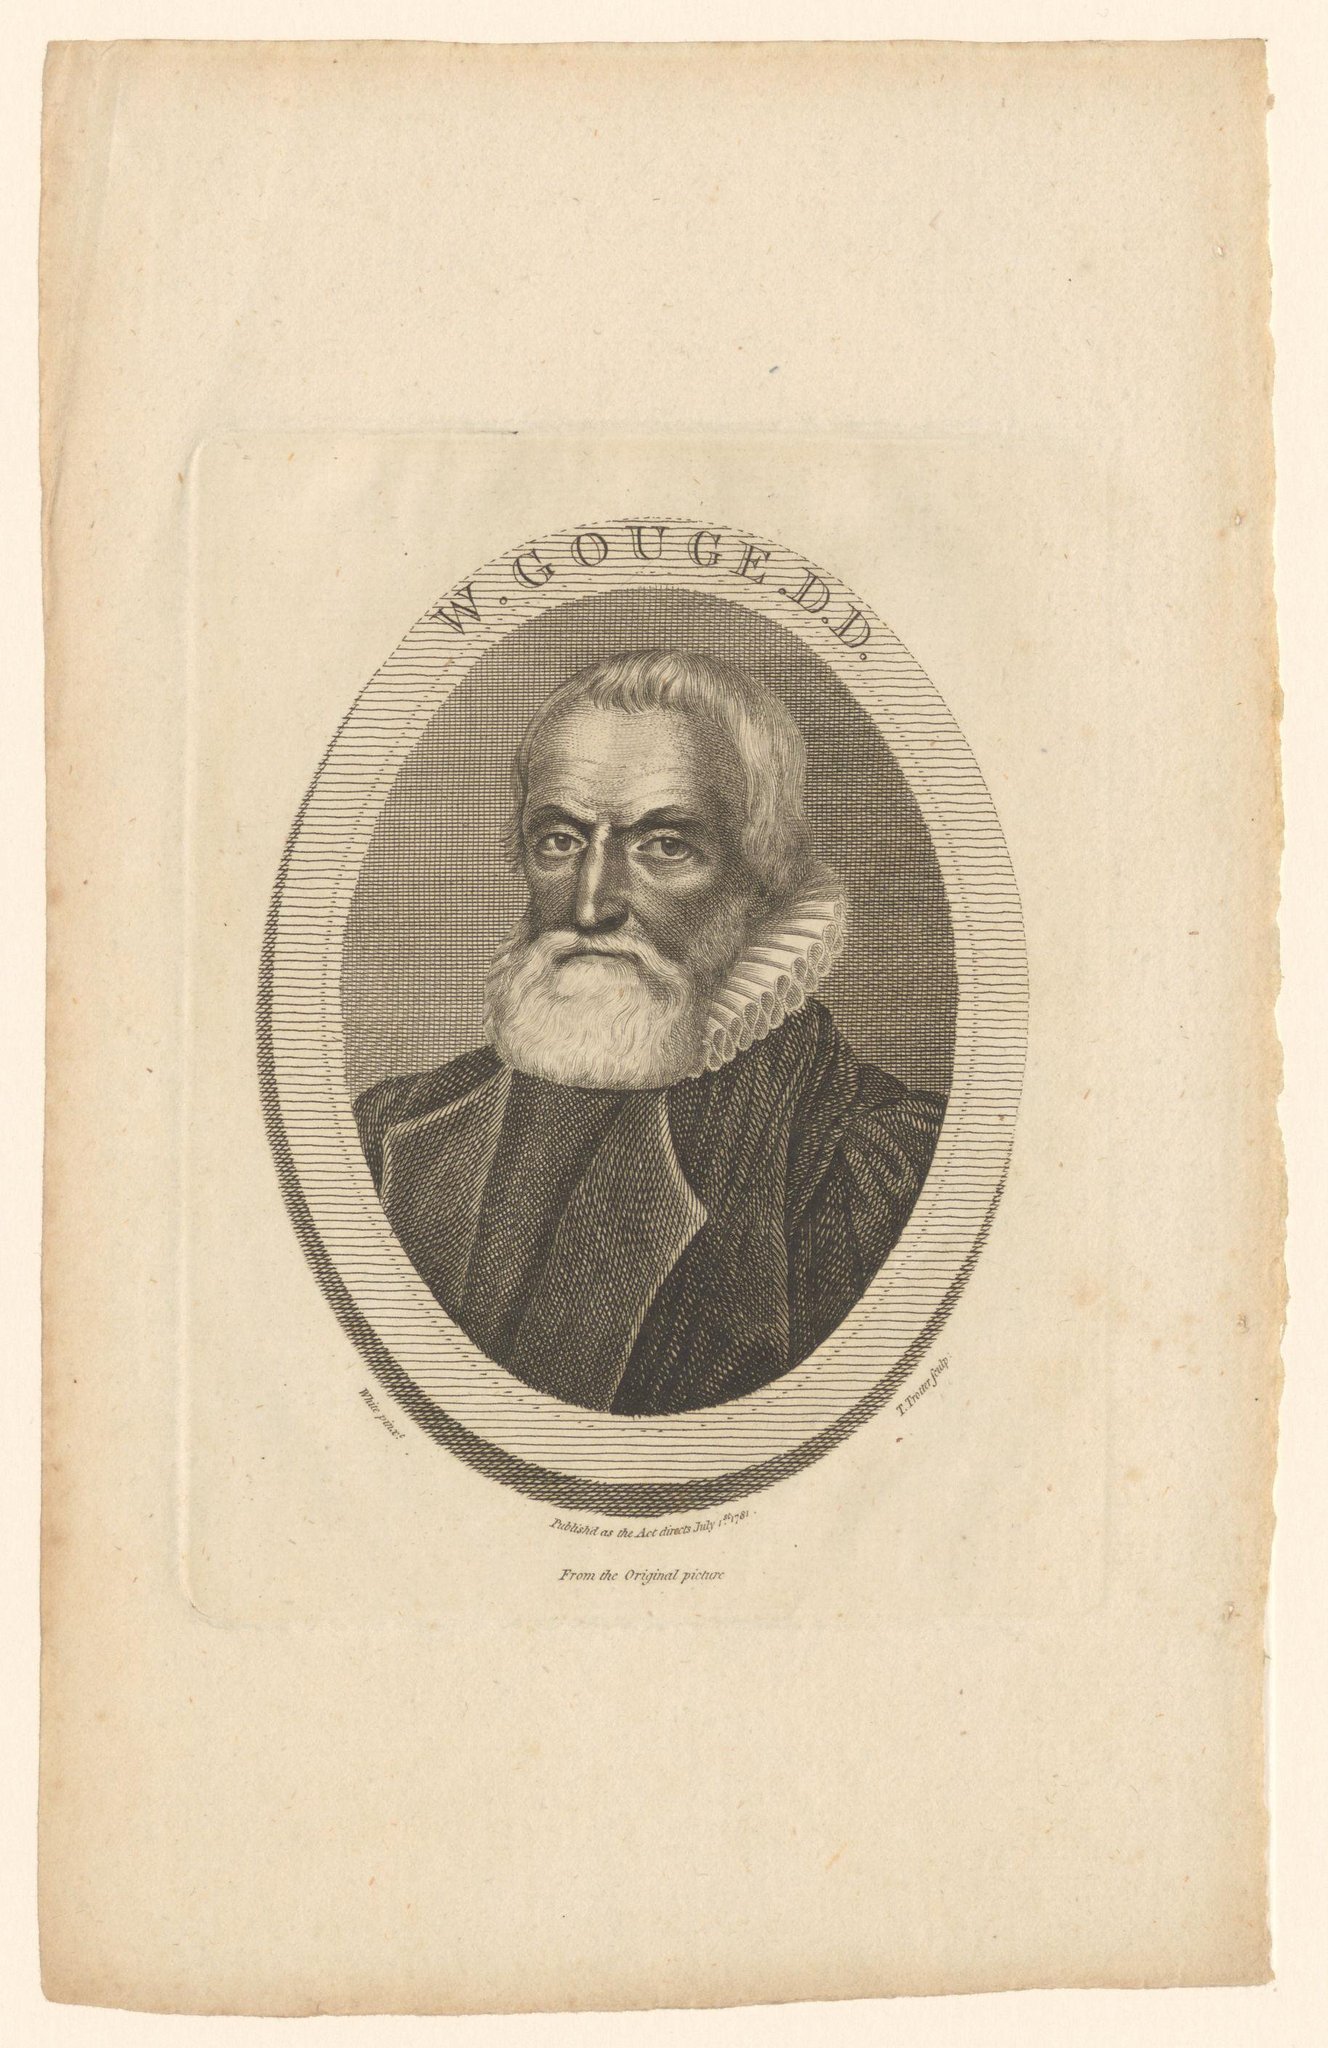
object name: book illustration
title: Portret van William Gouge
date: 1707-1781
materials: paper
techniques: engraving, etching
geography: london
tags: historical persons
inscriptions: collector's mark: Lugt 2228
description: Prent uit: Middleton, Erasmus. Biographia Evangelica (...). Londen: Alexander Hogg, 1781.